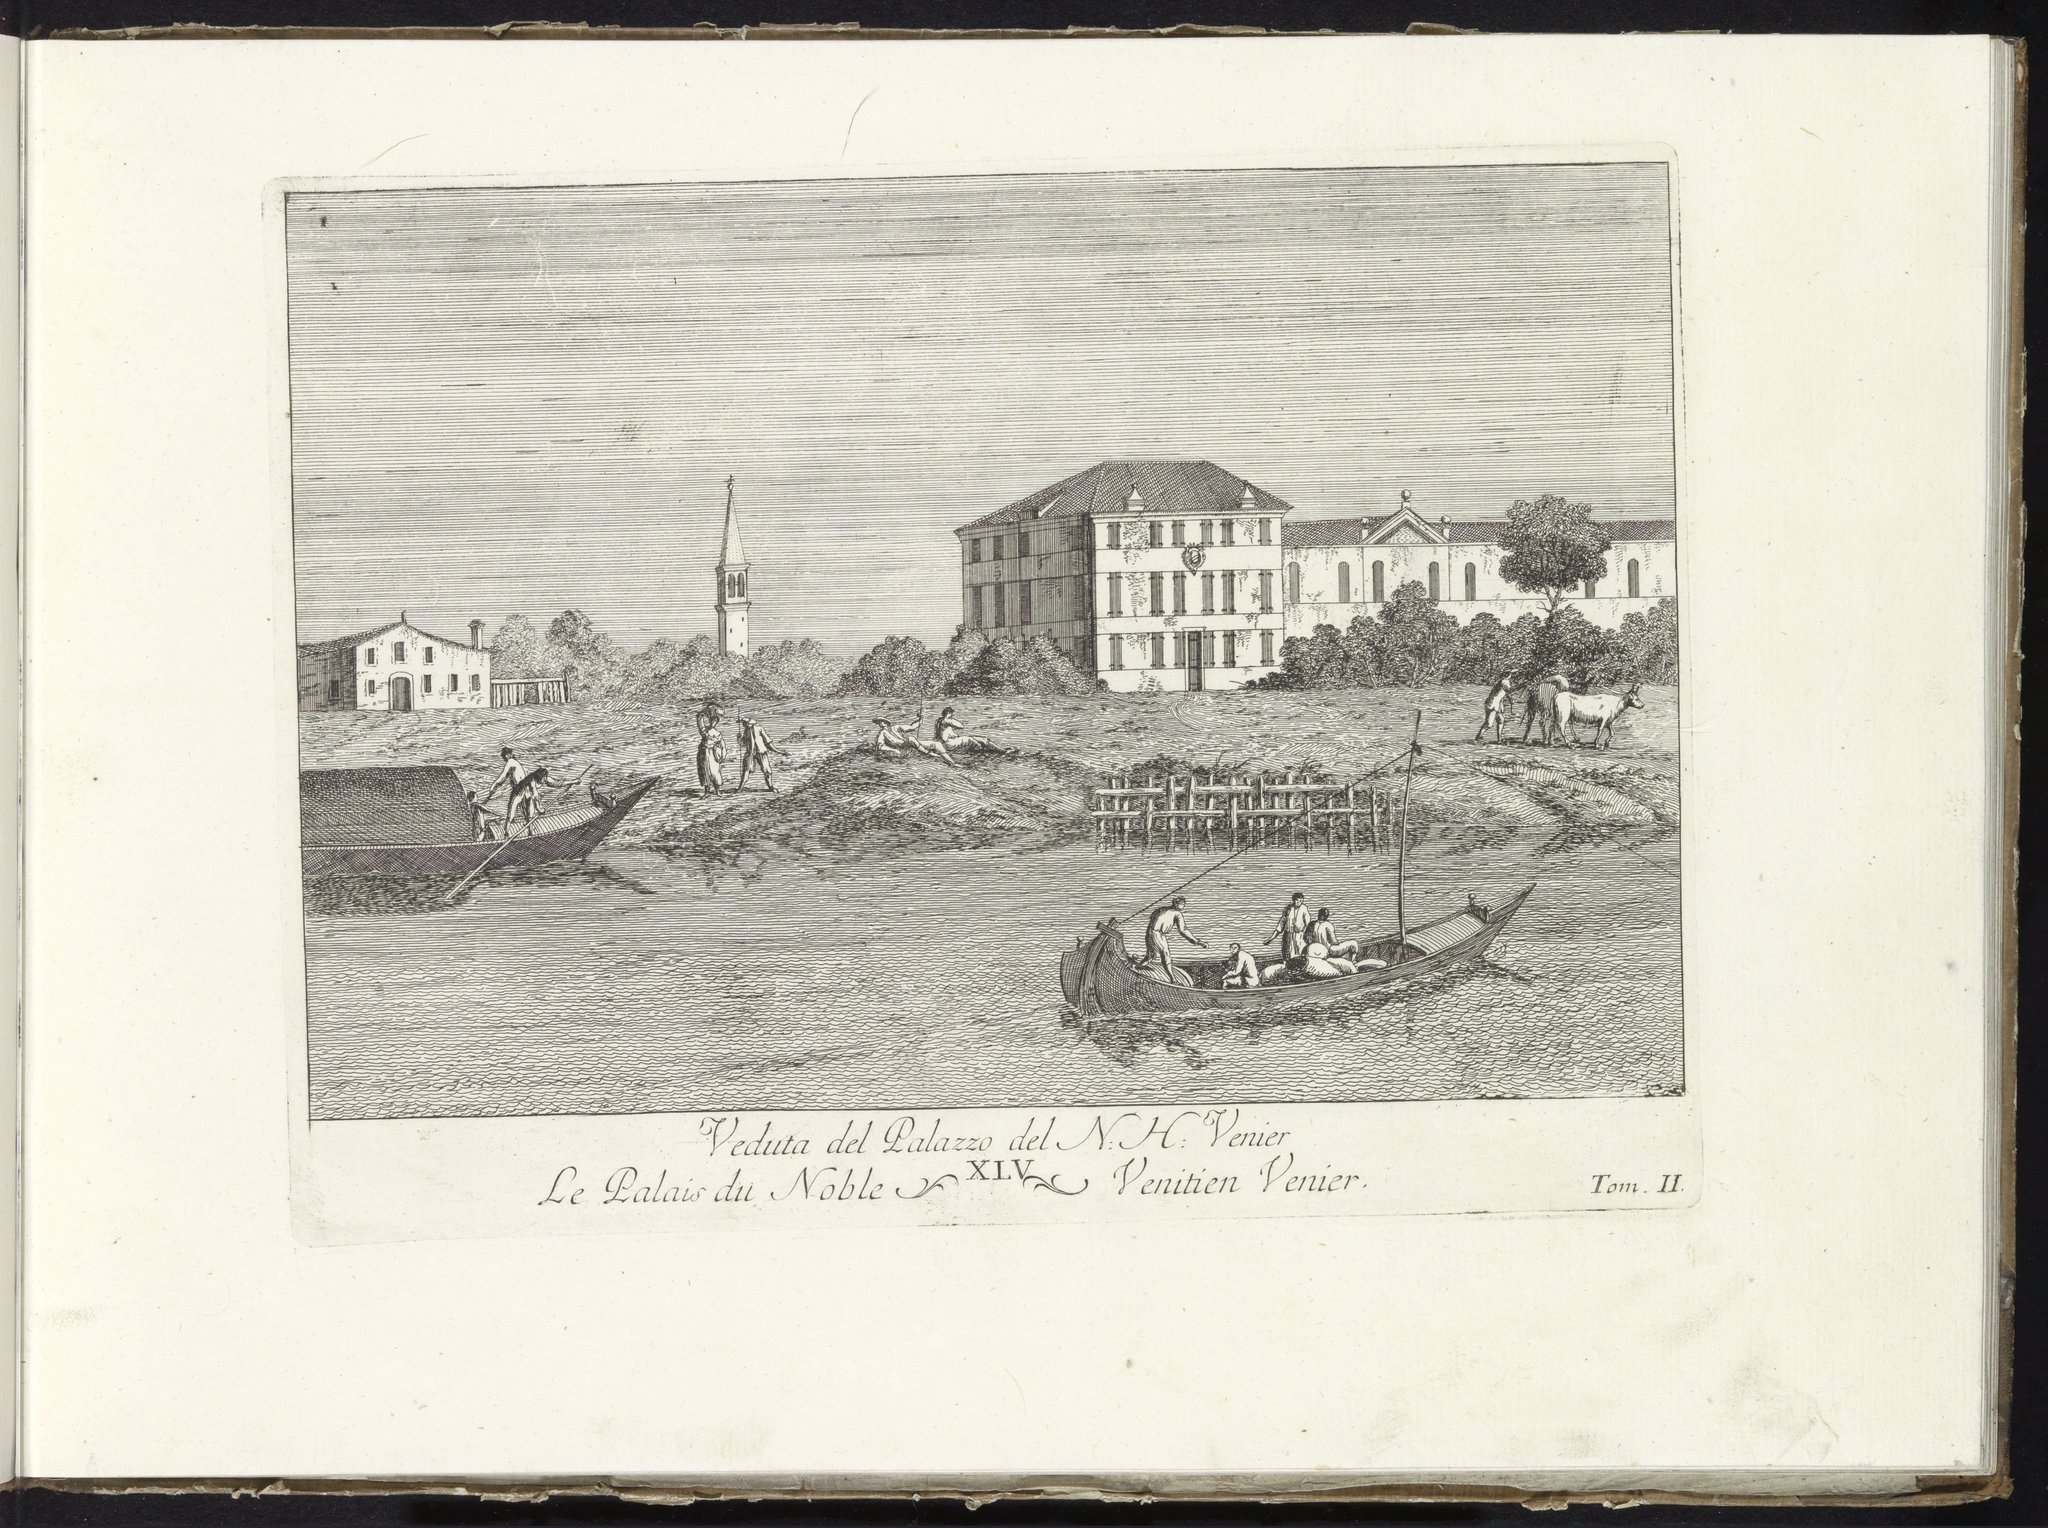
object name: print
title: Le delicie della Brenta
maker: giovanni francesco costa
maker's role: draughtsman, painter, print maker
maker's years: -1773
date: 1750-1760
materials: paper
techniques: etching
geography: italy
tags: river, tow-boat, towing-barge, hôtel, i.e. small palace in city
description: Gezicht op Palazzo del N: H: Venier aan de rivier de Brenta. Op het water vaart een trekschuit. Genummerd midden onder: XLV en rechtsonder: Tom: II. Deze prent maakt deel uit van een album.